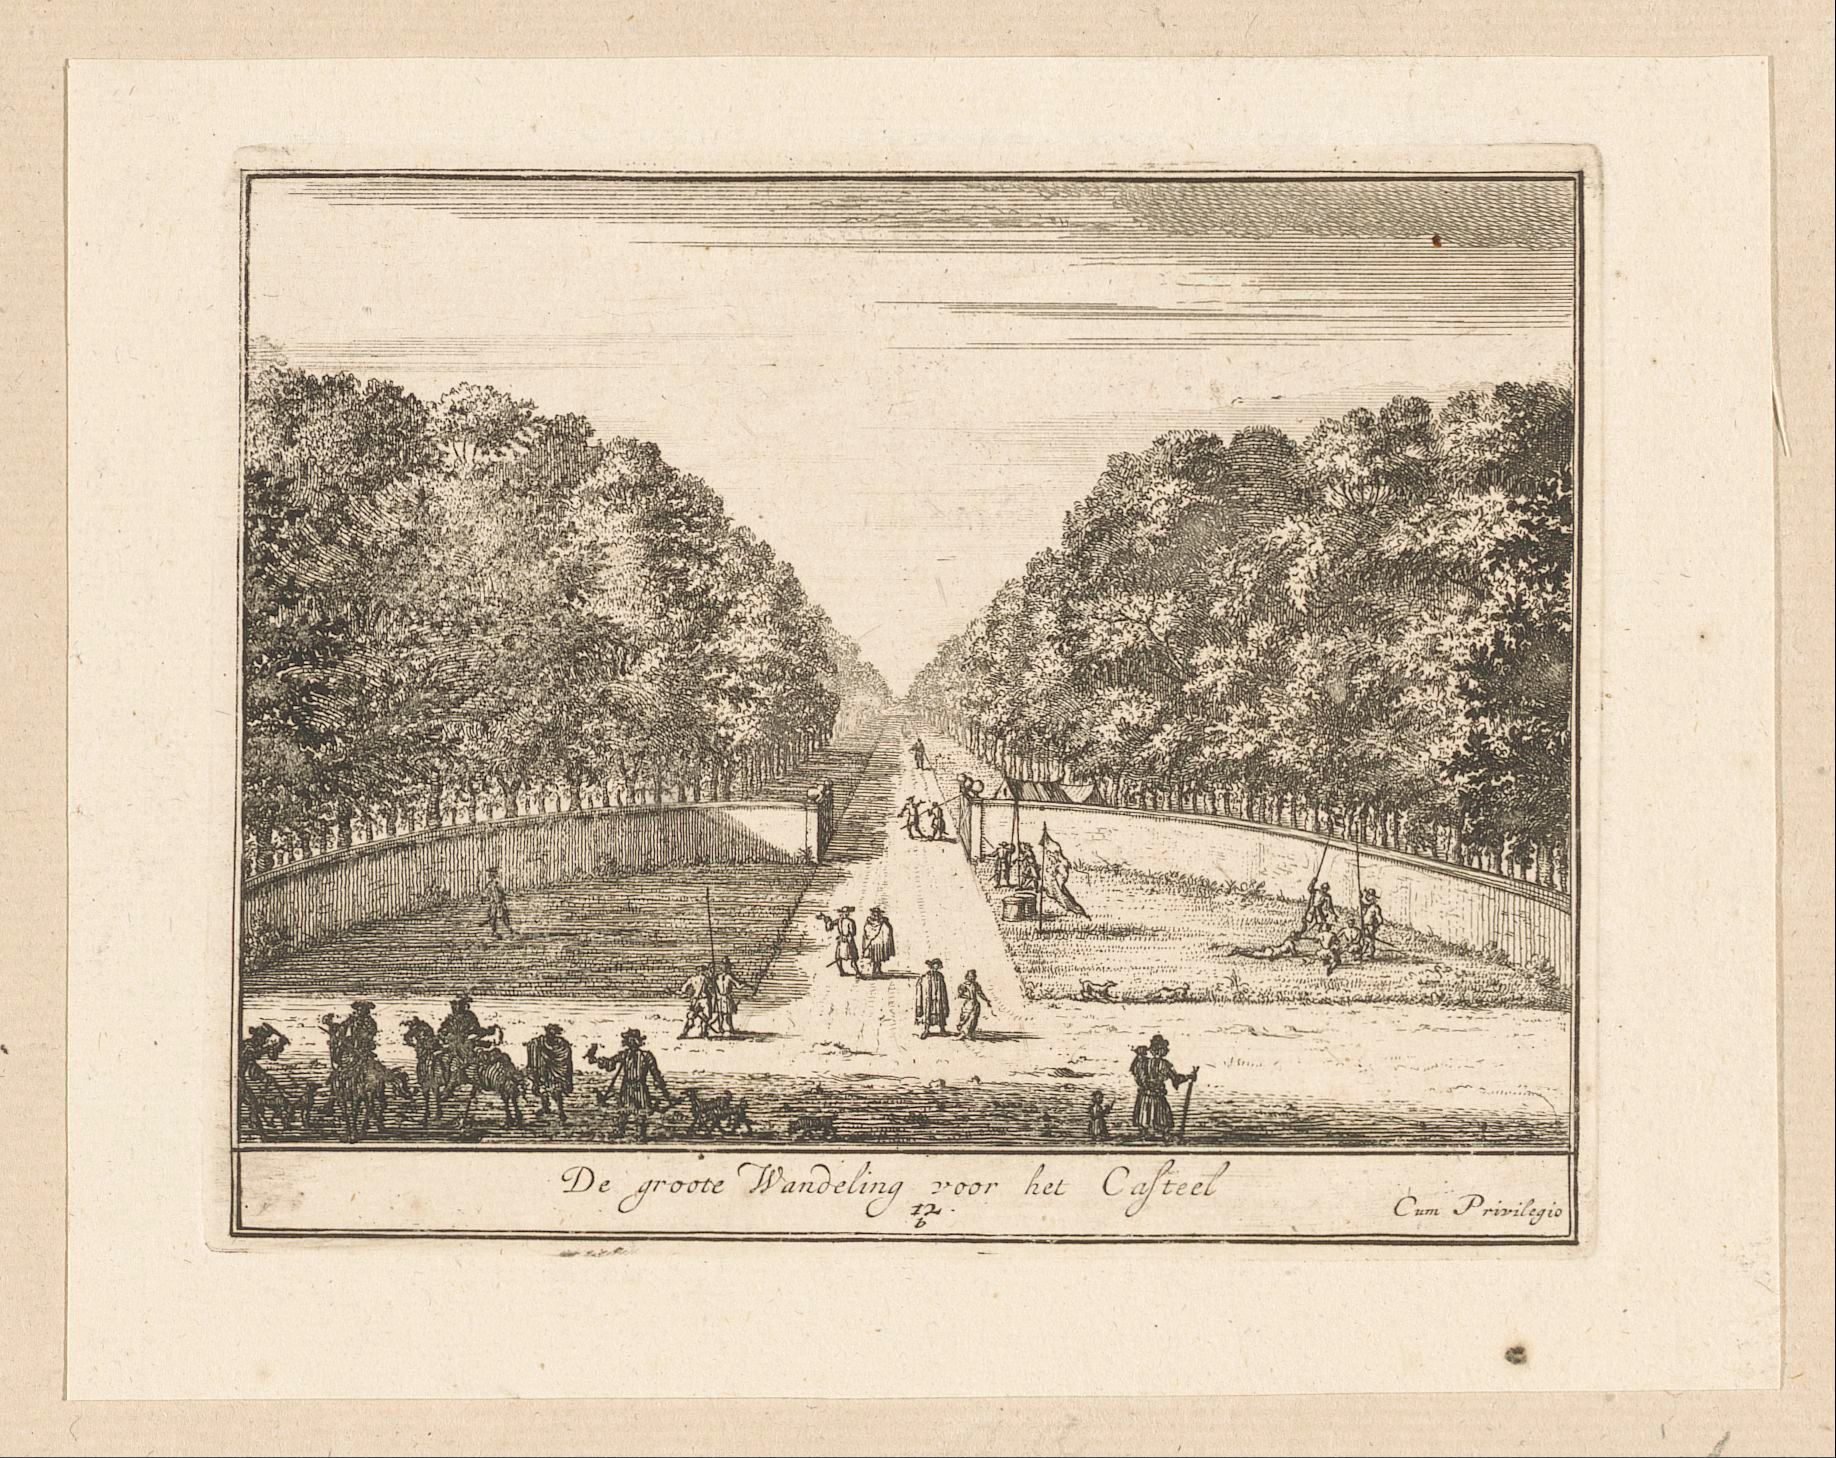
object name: print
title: De groote wandeling voor het casteel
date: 1695-1757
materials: paper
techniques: engraving, etching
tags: palace, road, path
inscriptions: collector's mark: Lugt 2233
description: Onderdeel van een serie van zestien prenten van Paleis Honselaarsdijk, oorspronkelijk gemaakt (en waarschijnlijk ook uitgegeven) door Abraham Bloteling rond 1684. Op de eerste staat van de prenten stond zijn naam linksonder, de sporen hiervan zijn met name op de negende prent (RP-P-AO-11-80-9B) nog duidelijk te zien. Deze staat van de serie is zeldzaam, mogelijk bezit de Bibliothèque Nationale een exemplaar. Zijn schoonbroer Gerard Valck heeft de reeks vervolgens in 1695 uitgegeven samen met drie andere prentseries onder de titel 'Veues et perspectives de Loo, Honslardyck et Soesdyck, chasteaux & maisons de plaisance du Roy de la Grande Bretagne, ausquels on a adjoûté les veuës des environs de Cleves', met voor de prenten van Honselaarsdijk de subtitel 'Veues et perspectives de Honslardyck, chasteau et maison de plaisance du Roy de la Grande Bretagne, le tout dessiné & gravé par les plus habiles maistres'. Valck heeft de platen aangepast waardoor van elke prent een tweede staat ontstond. Vervolgens zijn de platen in handen van Isaac Greve gekomen, die de serie nog een keer uitgaf onder de titel '16. gesigte van 't koninglyke lust huys Honslardyk'. Vermoedelijk heeft Greve alleen de plaat van de eerste prent bijgewerkt en de rest onveranderd gelaten waardoor van de eerste prent drie staten bekend zijn en van de rest twee.